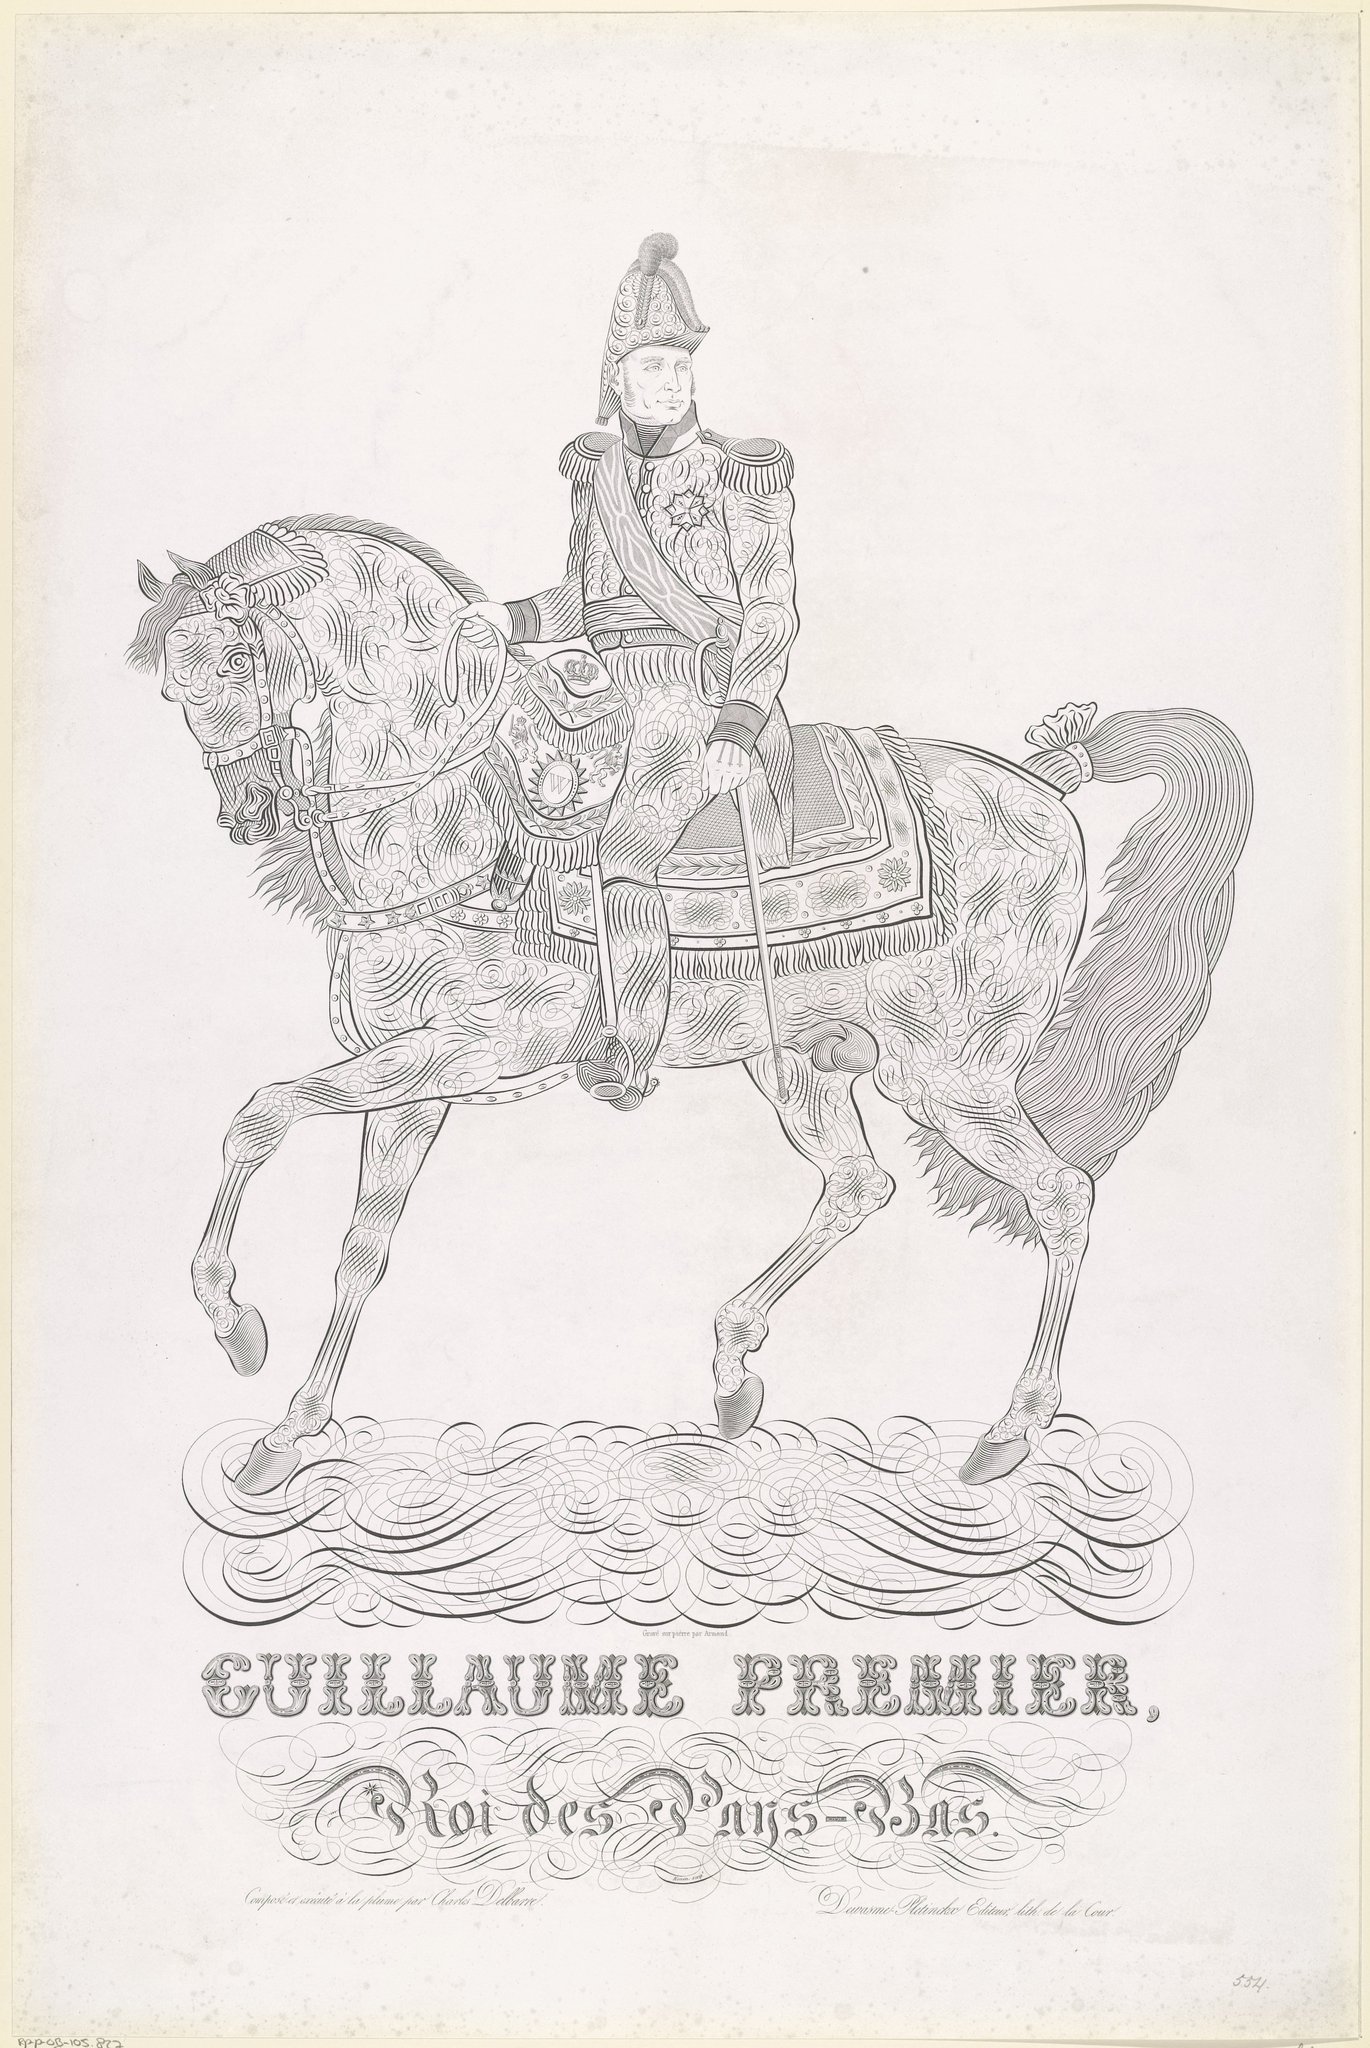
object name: print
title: Ruiterportret van Willem I Frederik, koning der Nederlanden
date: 1815-1851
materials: paper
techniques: lithograph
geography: brussels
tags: the hague, berlin, william i of the netherlands, equestrian state-portrait, king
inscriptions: collector's mark: Lugt 963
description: De hier vermelde titel verwijst naar de hoogst verkregen titel van de geportretteerde, niet per se naar de titel die de geportretteerde op deze voorstelling draagt.